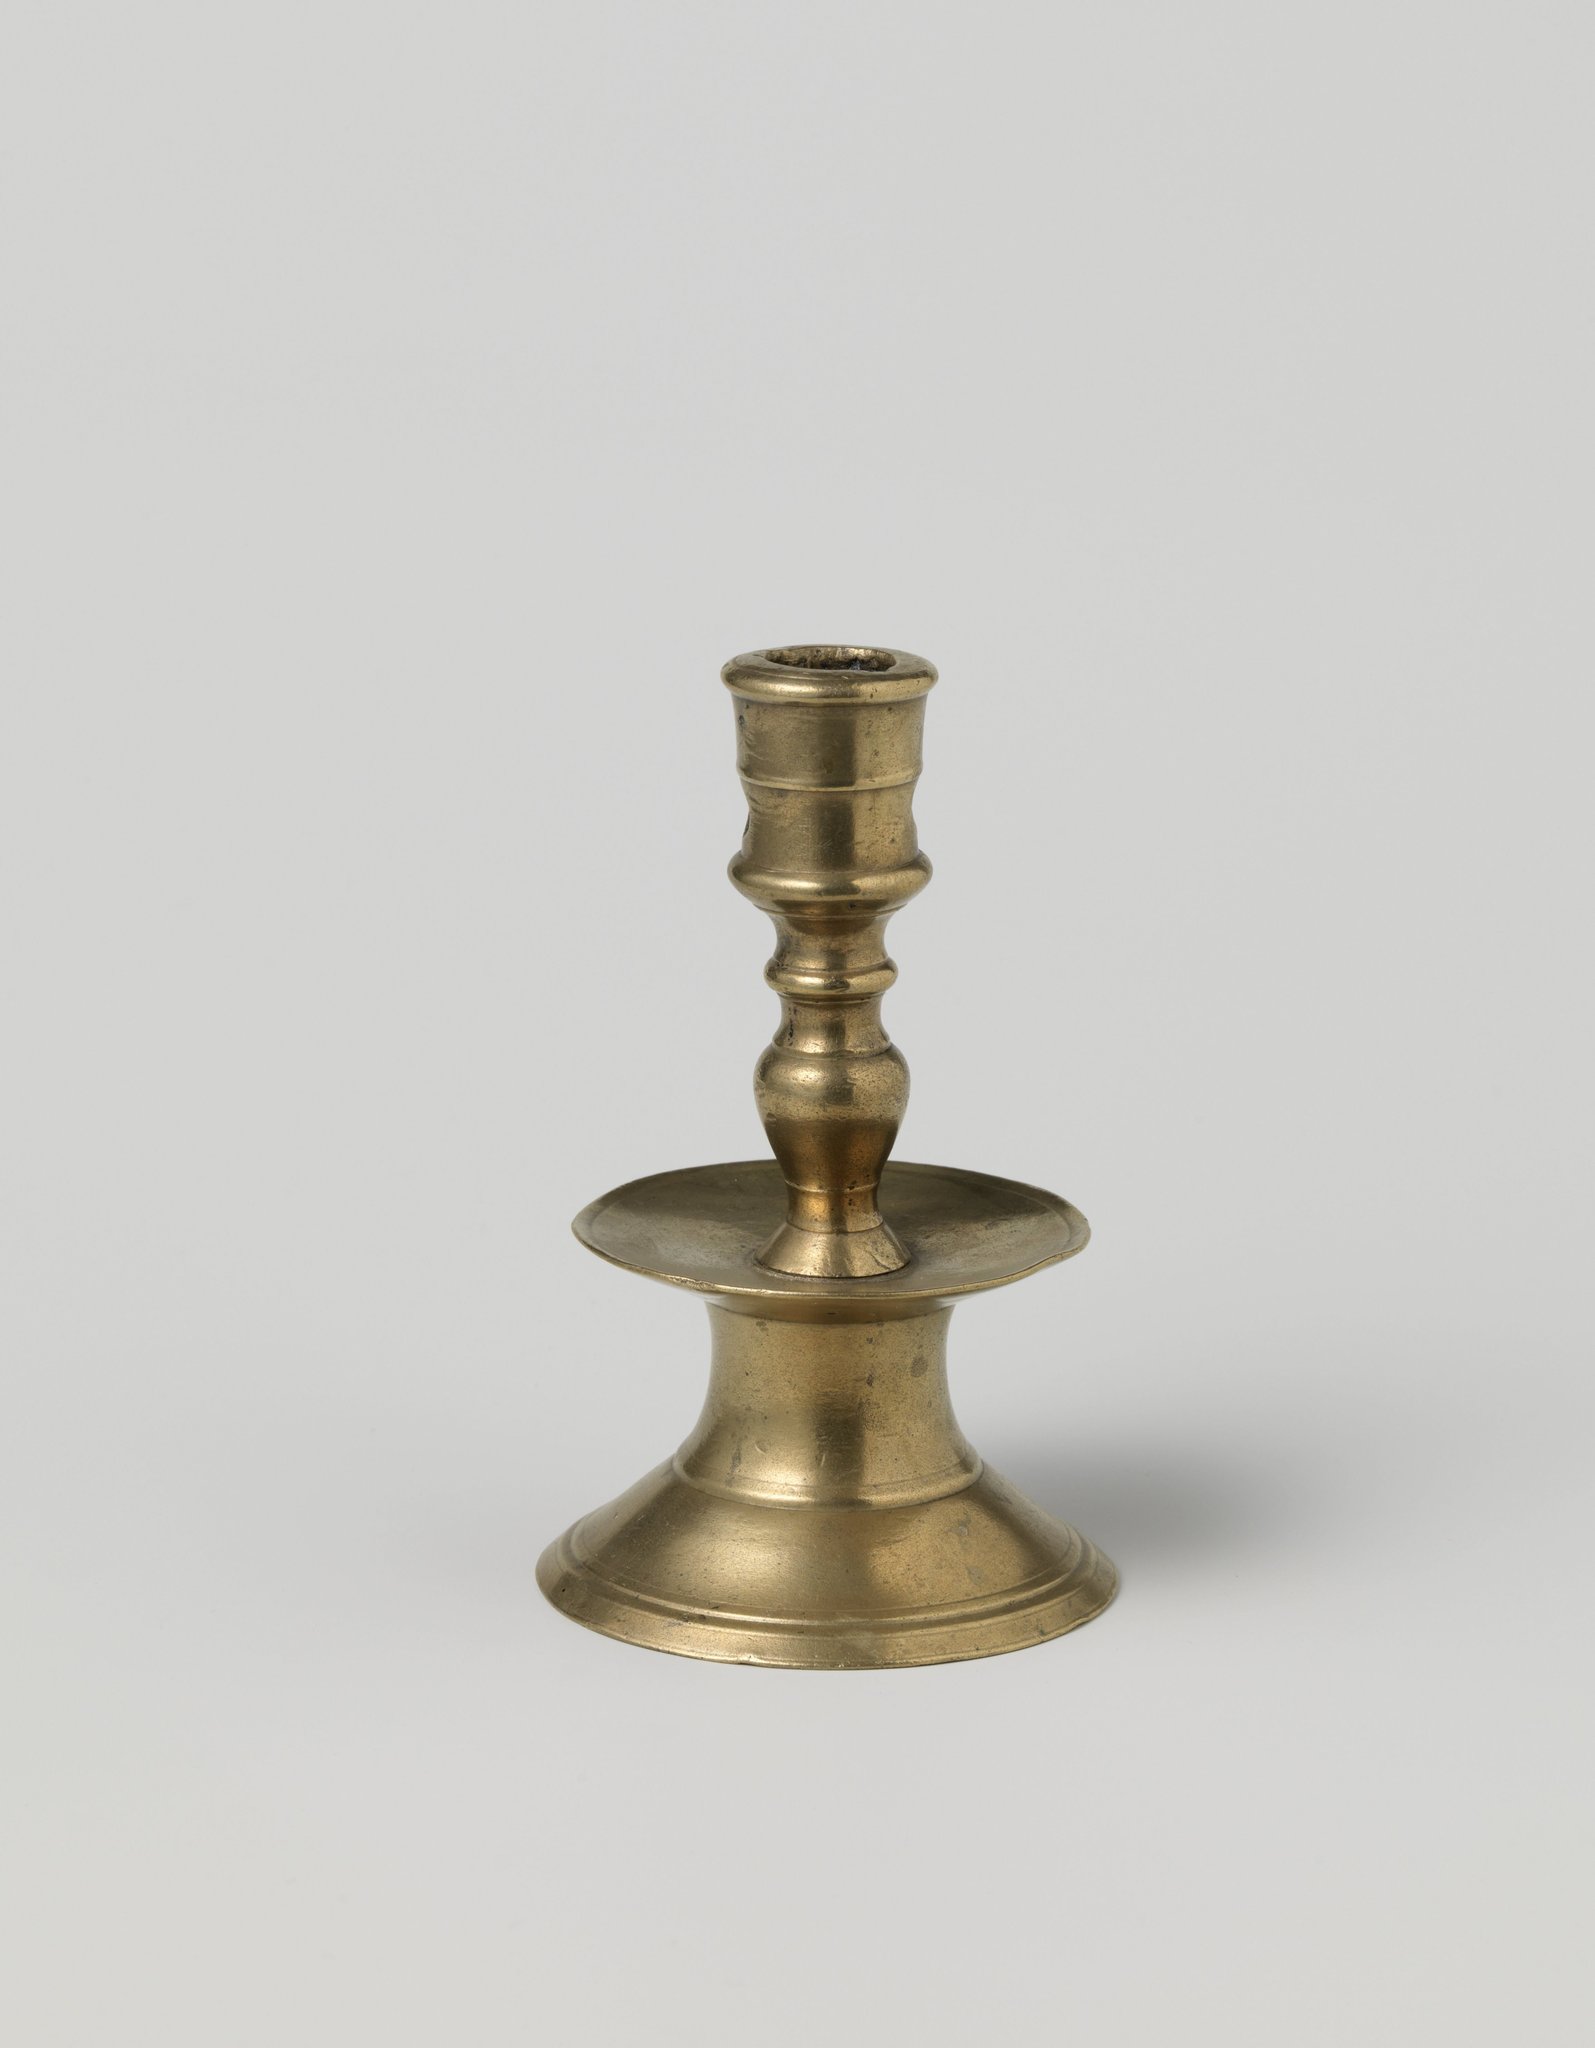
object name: lighting device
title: Kraag- of schijfkandelaar van messing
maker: Anonymous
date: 1575-1625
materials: brass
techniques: casting, riveted, turning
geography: southern netherlands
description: De kandelaar is samengesteld uit twee gegoten en afgedraaide delen: de voet met de vetvanger en de stam met de kaarsenhouder. De konische voet gaat naar boven toe over in een brede vetvanger, de kraag. De in de voet geklonken stam is balustervormig. De cylindrische houder heeft in de wand twee ronde openingen. Voet en kraag zijn versierd met profielen.